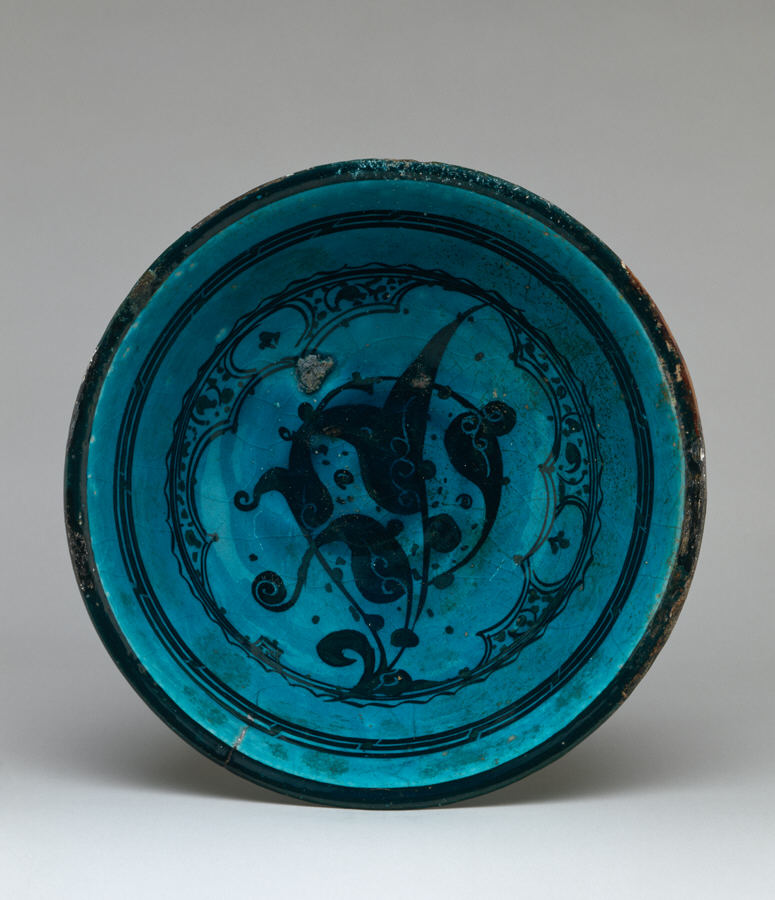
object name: bowl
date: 1101-1300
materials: glaze, stonepaste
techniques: incising, painting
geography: syria